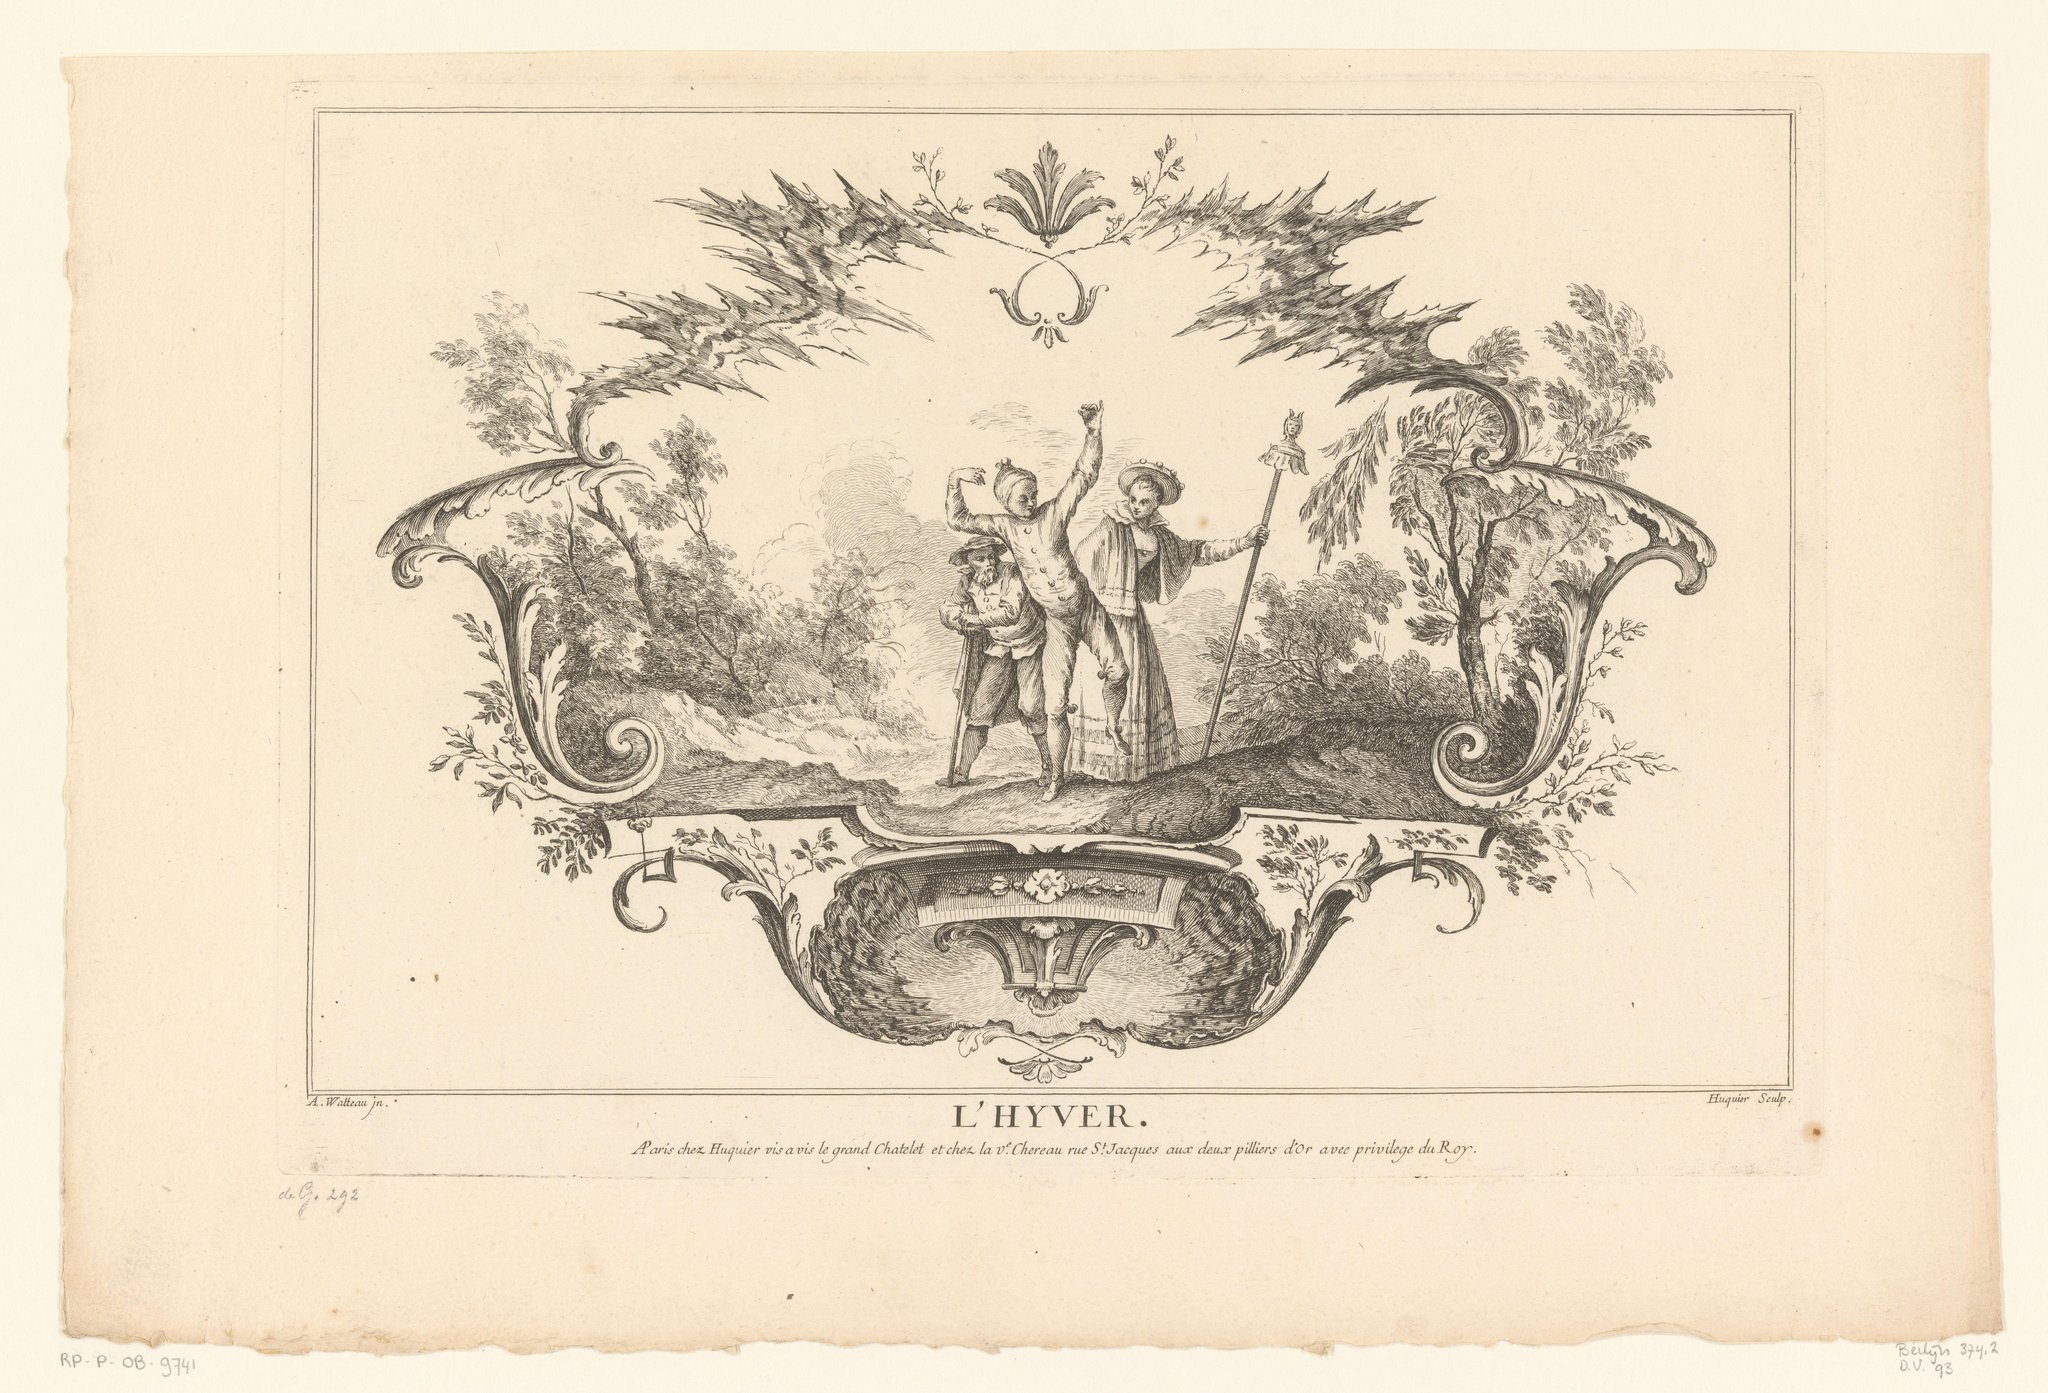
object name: print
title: L'Hyver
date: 1729-1734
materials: paper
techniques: etching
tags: winter, 'hyems'; 'inverno' (ripa)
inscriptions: collector's mark: Lugt 2228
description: In een landschap kijken een oude man en een vrouw met een narrenstok naar een dansende jongeman. Rondom de voorstelling een rocaille omlijsting.